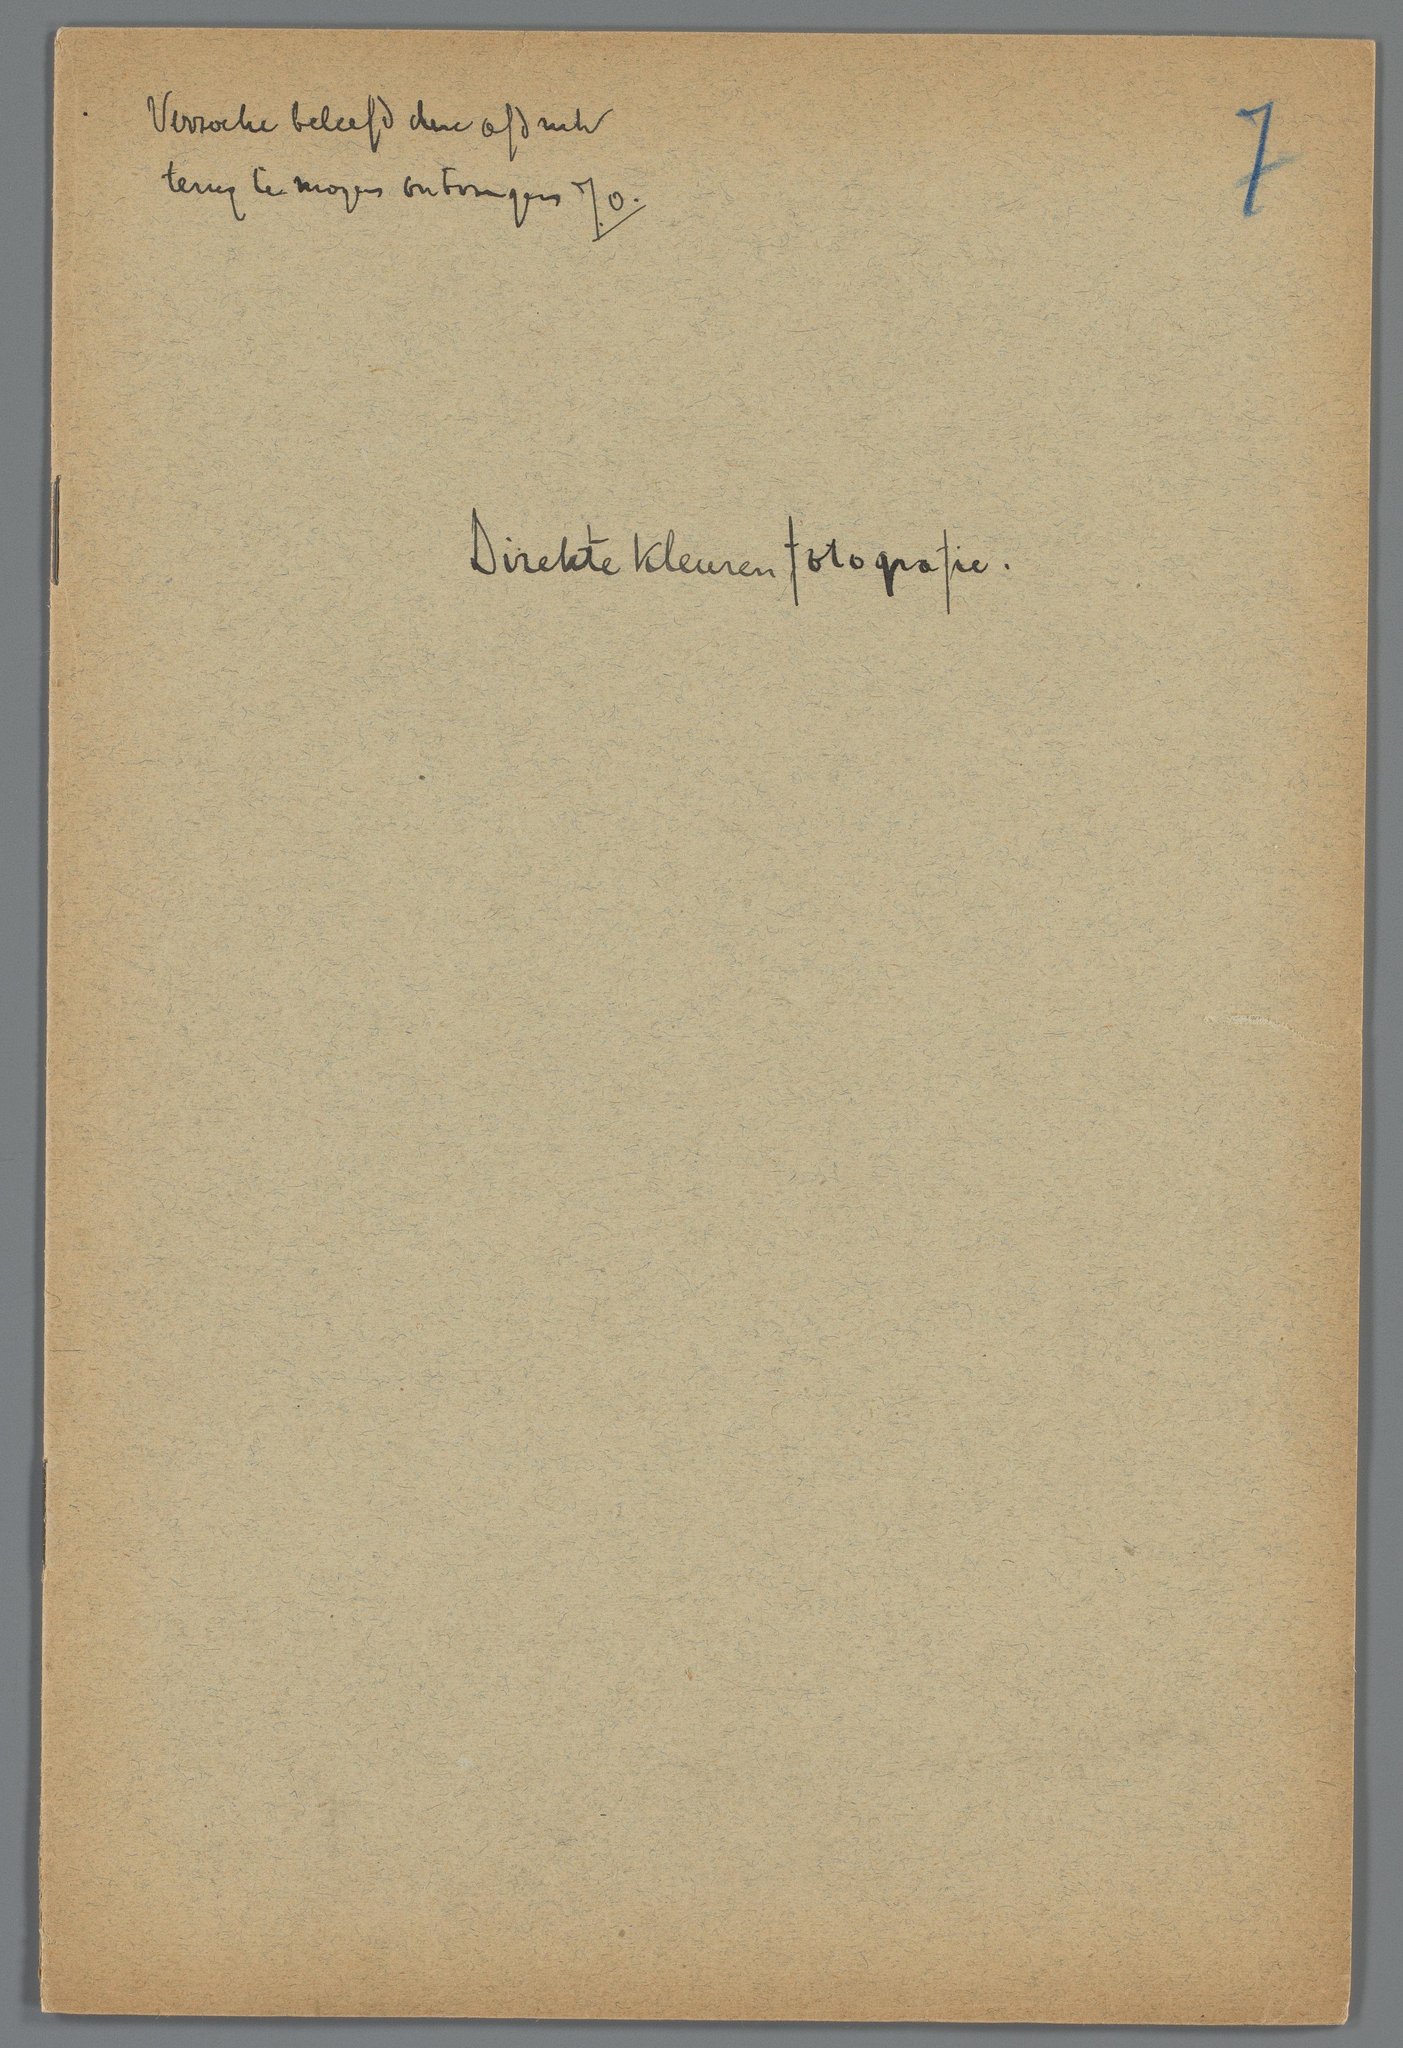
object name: offprint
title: Beschrijving over directe kleurenfotografie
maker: jacob olie jr.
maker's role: fotograaf, scheikundige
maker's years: 1879-1955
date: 1906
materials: paper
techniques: letterpress printing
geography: amsterdam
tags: printed matter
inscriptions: number: ‘7’, inscription: ‘Verzoeken beleefd den afdruk/ terug te mogen ontvangen Jo’, inscription: ‘Direkte kleuren fotografie.’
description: Overdruk uit het Chemisch Weekblad, nummer 28, 1906.